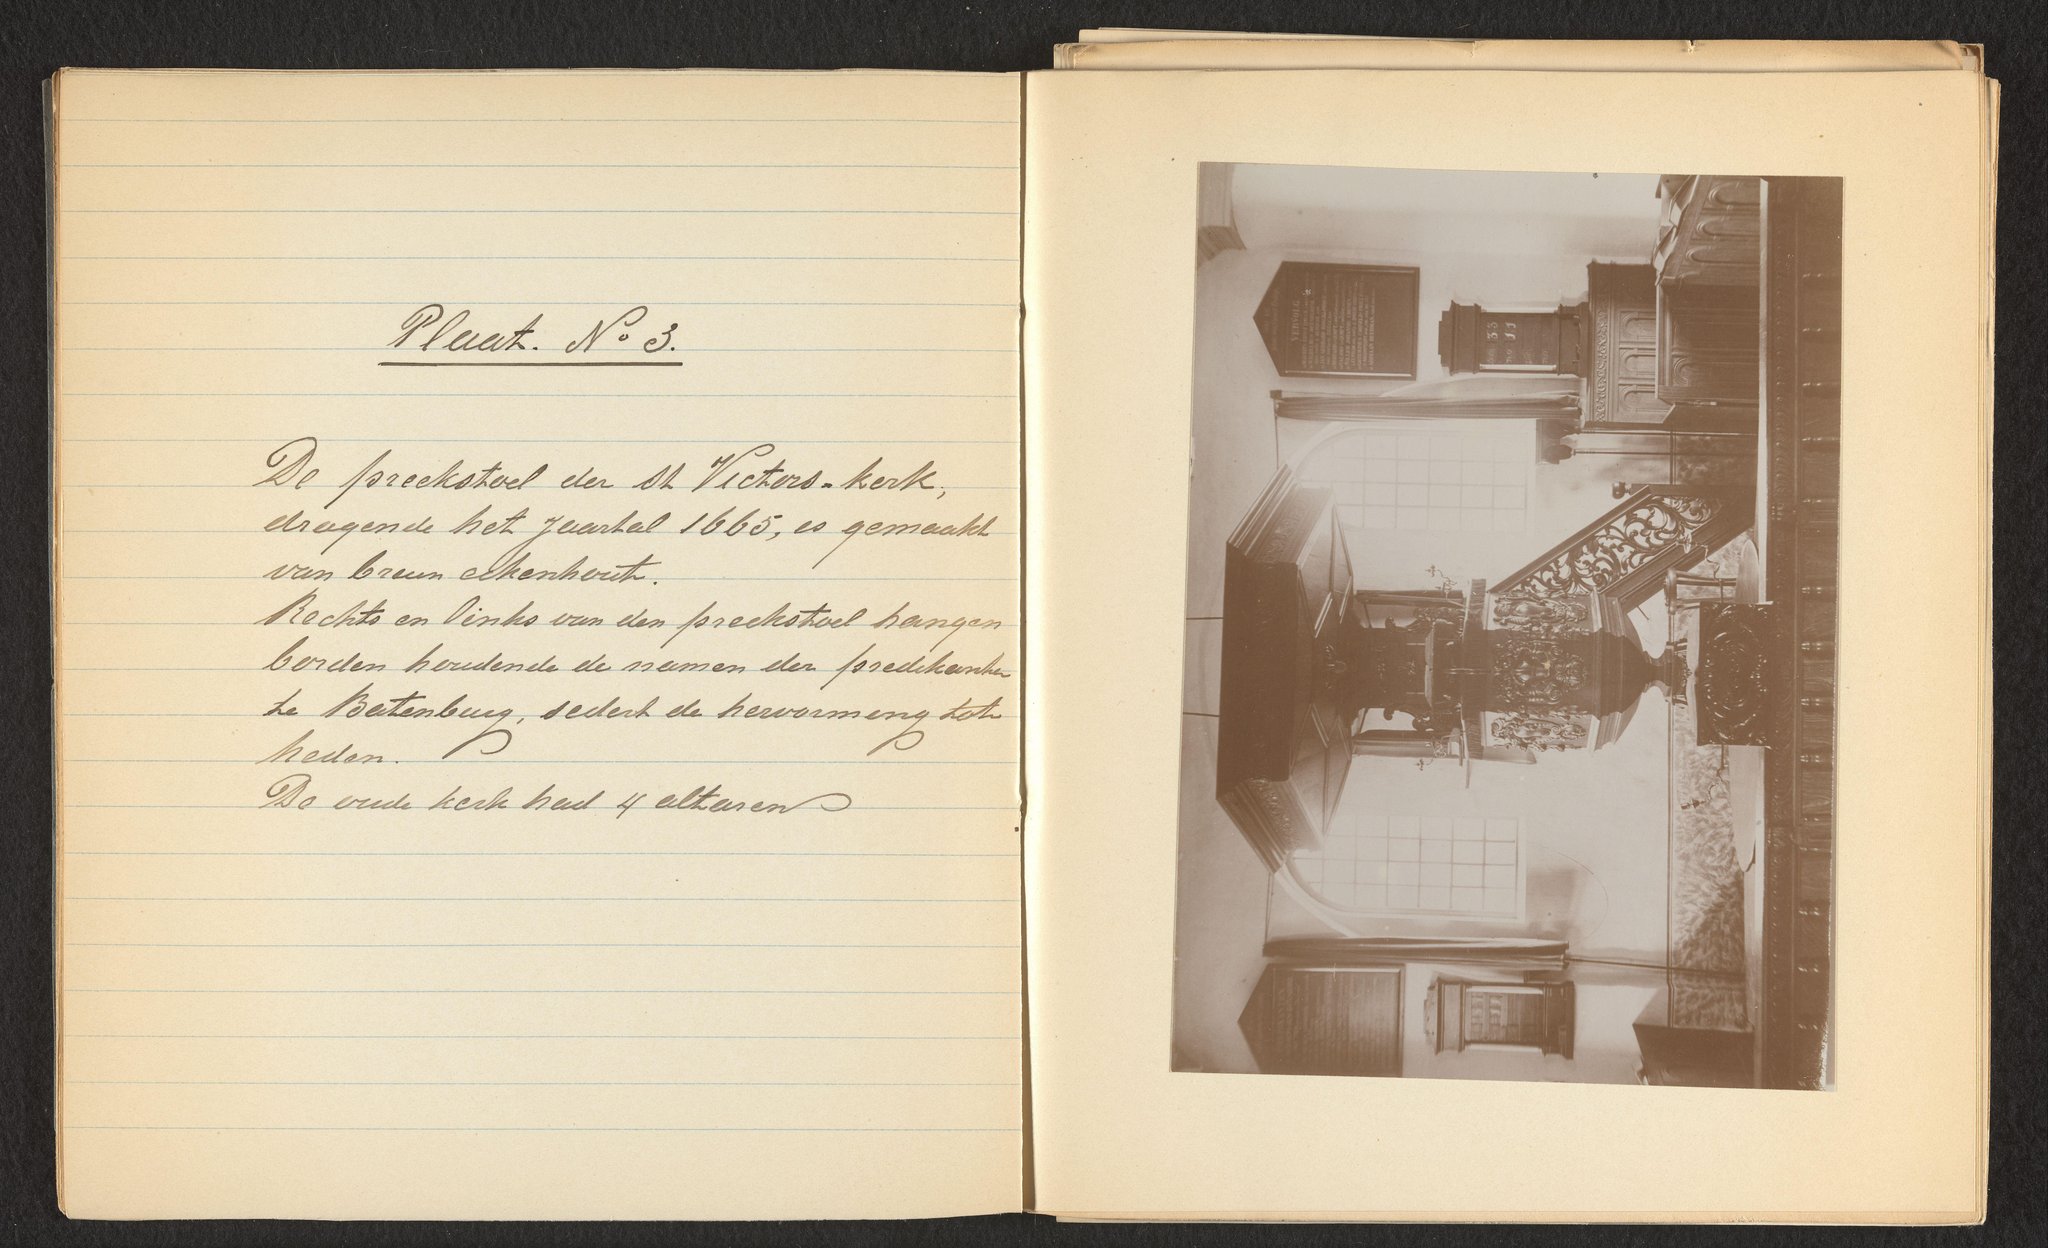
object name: page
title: Preekstoel in de Oude Sint-Victorkerk in Batenburg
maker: benjamin charlé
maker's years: 1845-1925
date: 1903-1908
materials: paper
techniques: collodion silver print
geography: batenburg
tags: pulpit, ambo, chancel